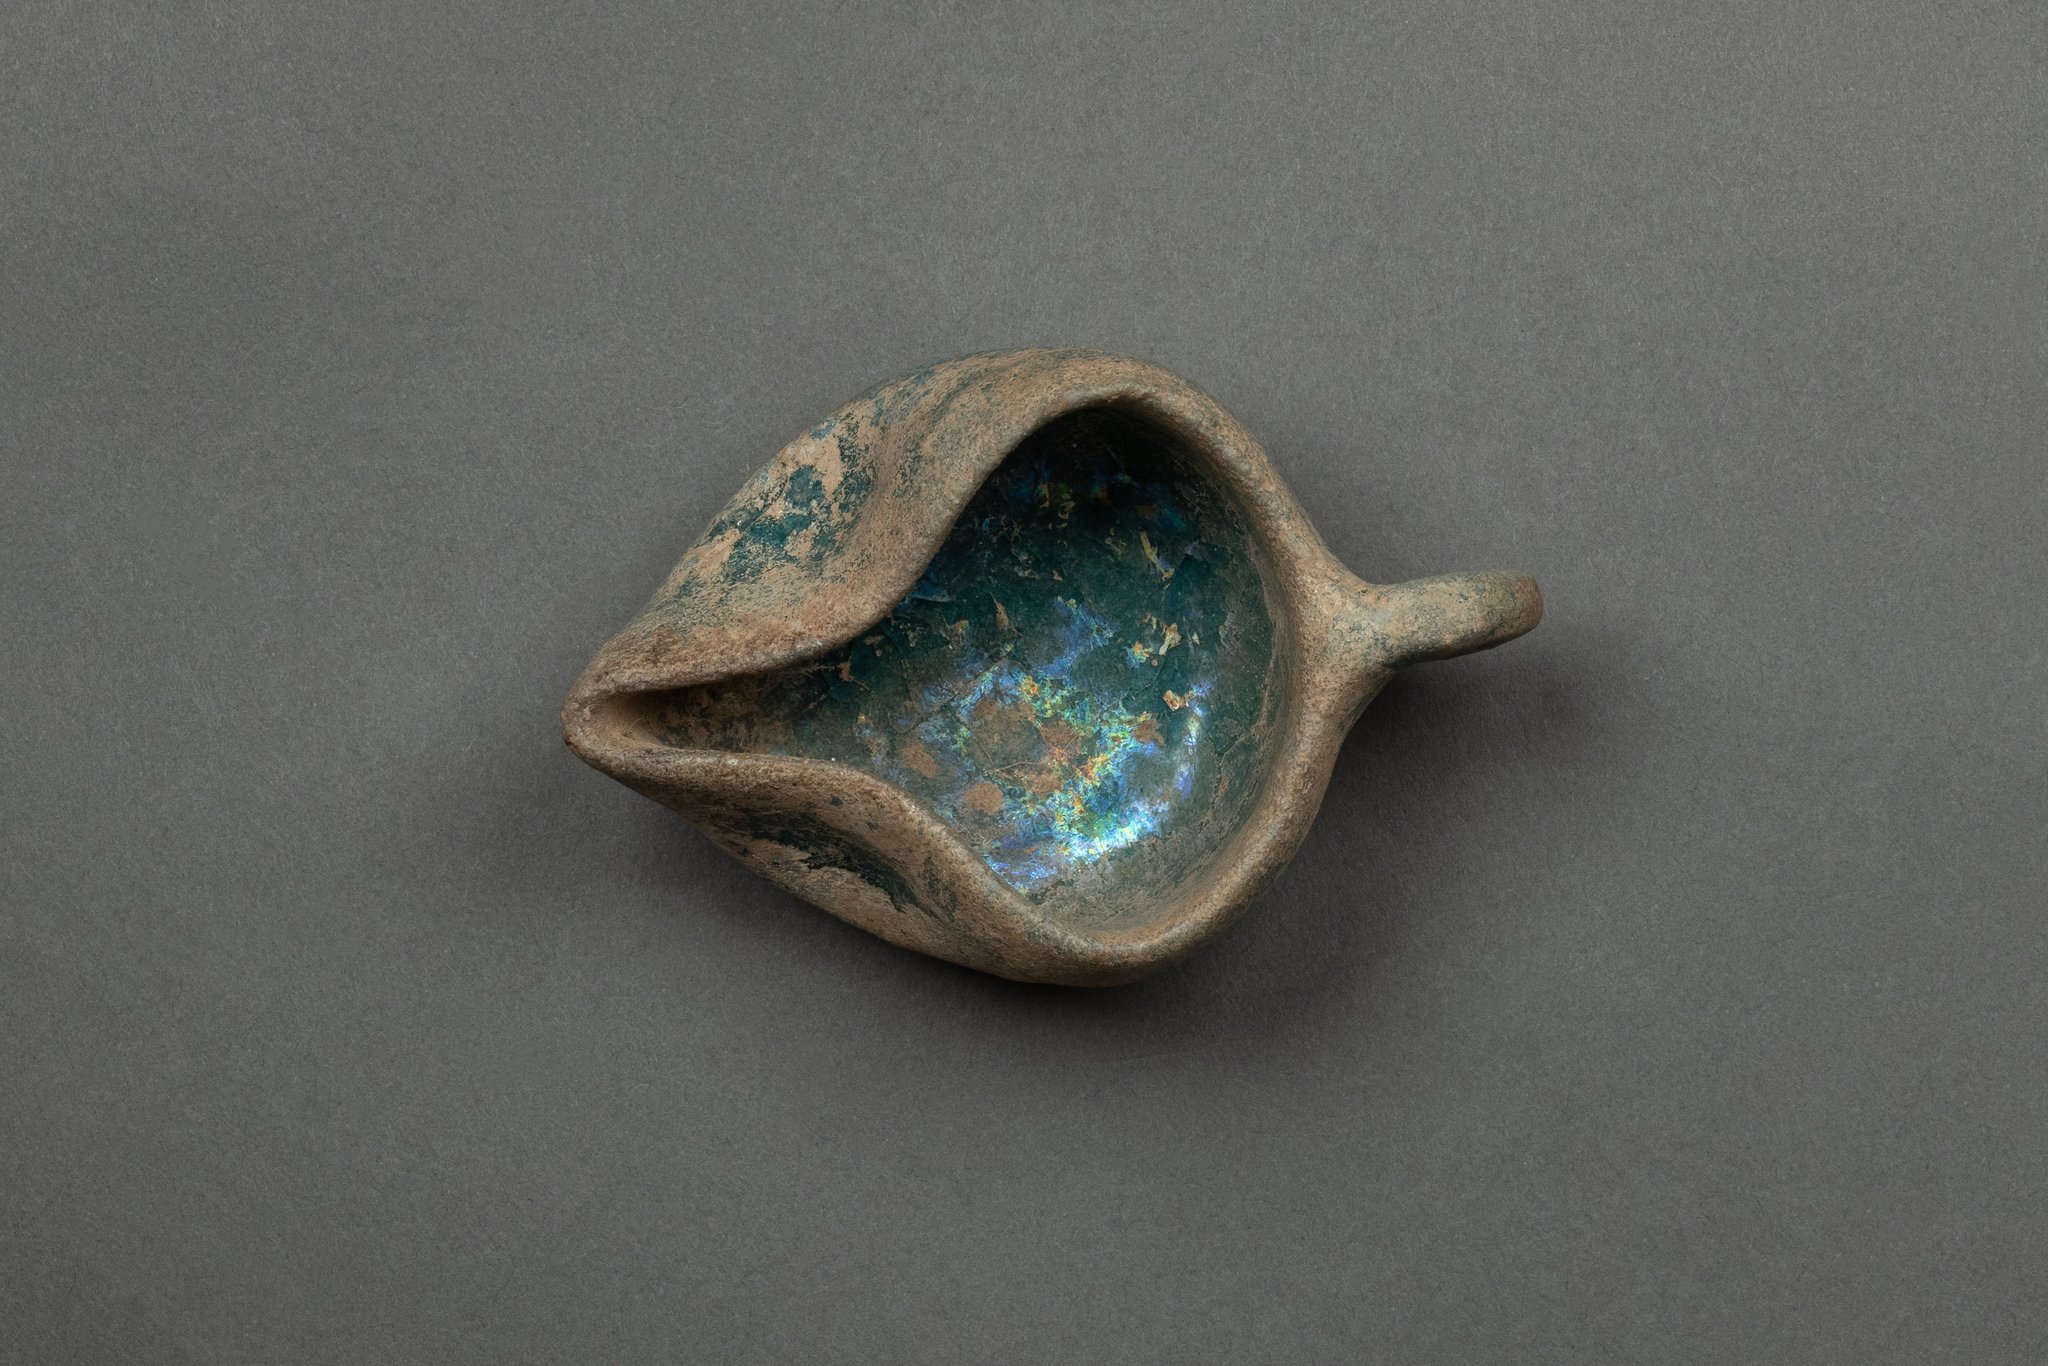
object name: lamp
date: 1001-1100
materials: glaze, stonepaste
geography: iran